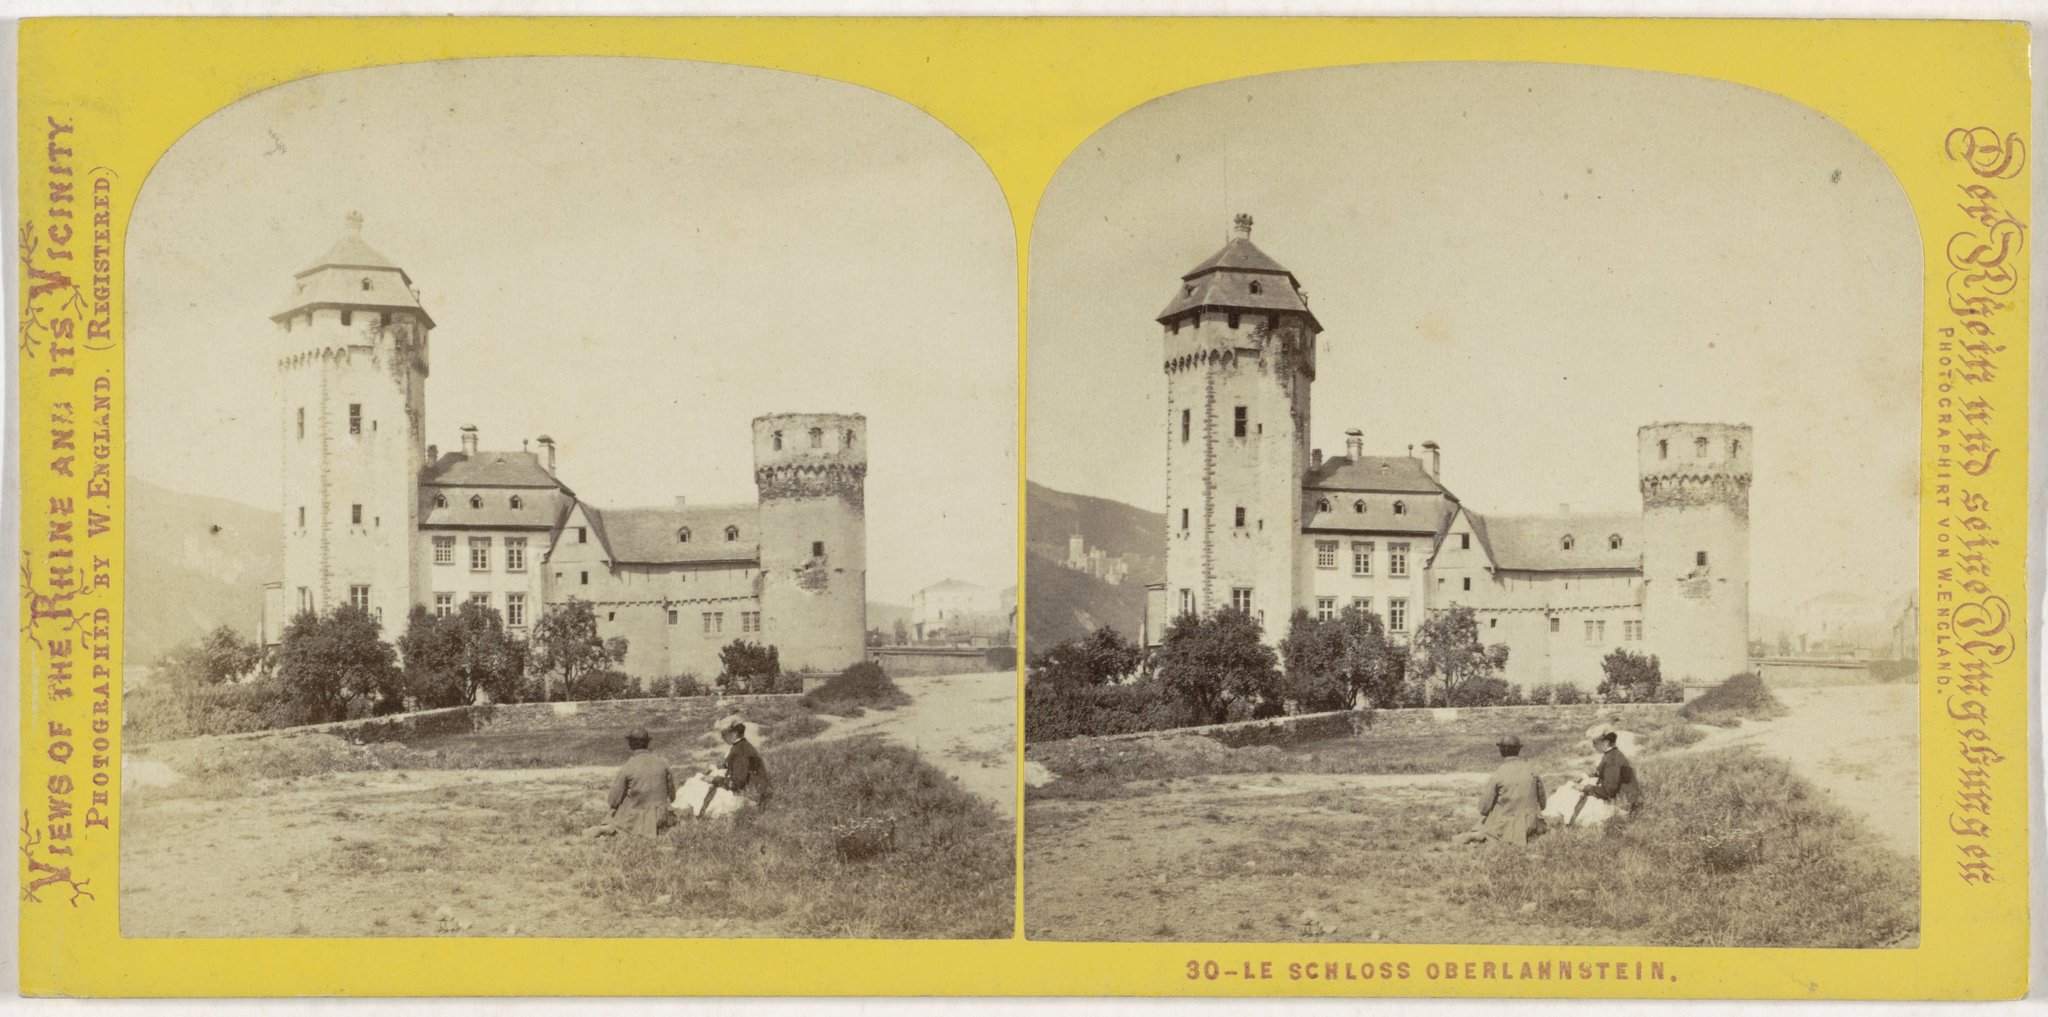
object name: stereograph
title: Slot Oberlahnstein, Duitsland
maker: william england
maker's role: fotograaf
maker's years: 1816-1896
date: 1867-1868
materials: cardboard, paper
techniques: albumen print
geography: lahnstein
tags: castle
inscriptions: number: ‘30’, inscription: ‘(Registered.)’